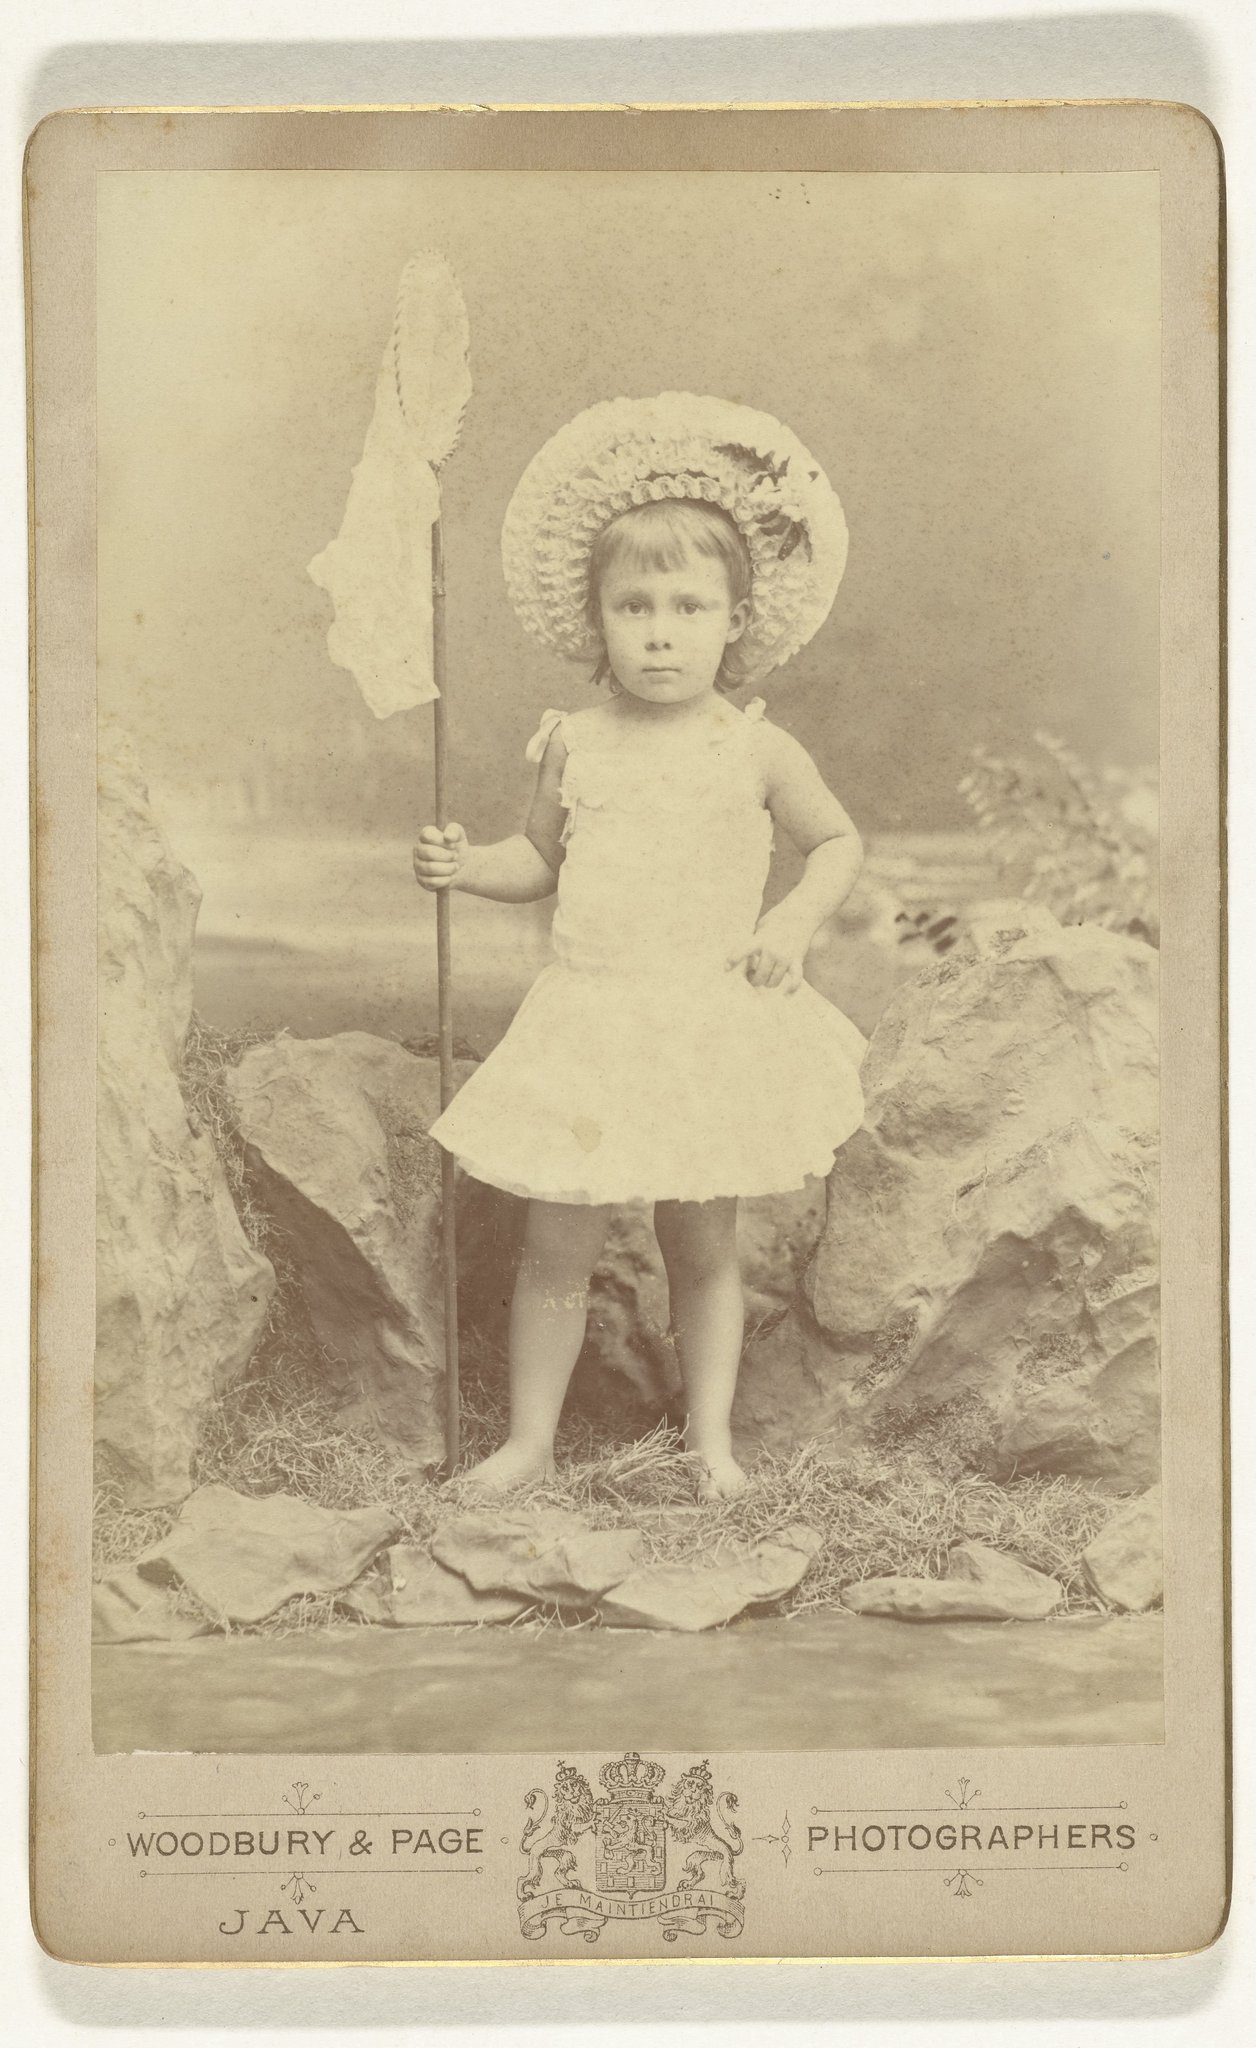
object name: album leaf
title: Studioportret van Tottie MacPherson met een schepnet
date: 1890-1910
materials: paper, photographic support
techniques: albumen print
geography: java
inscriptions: name: ‘Woodbury & Page Photographers, Java’, inscription: ‘Souvenir of your loving little frined Tottie MacPherson’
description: Studioportret van een meisje met een schepnet. Op de achtergrond een rotspartij en een achtergronddoek .